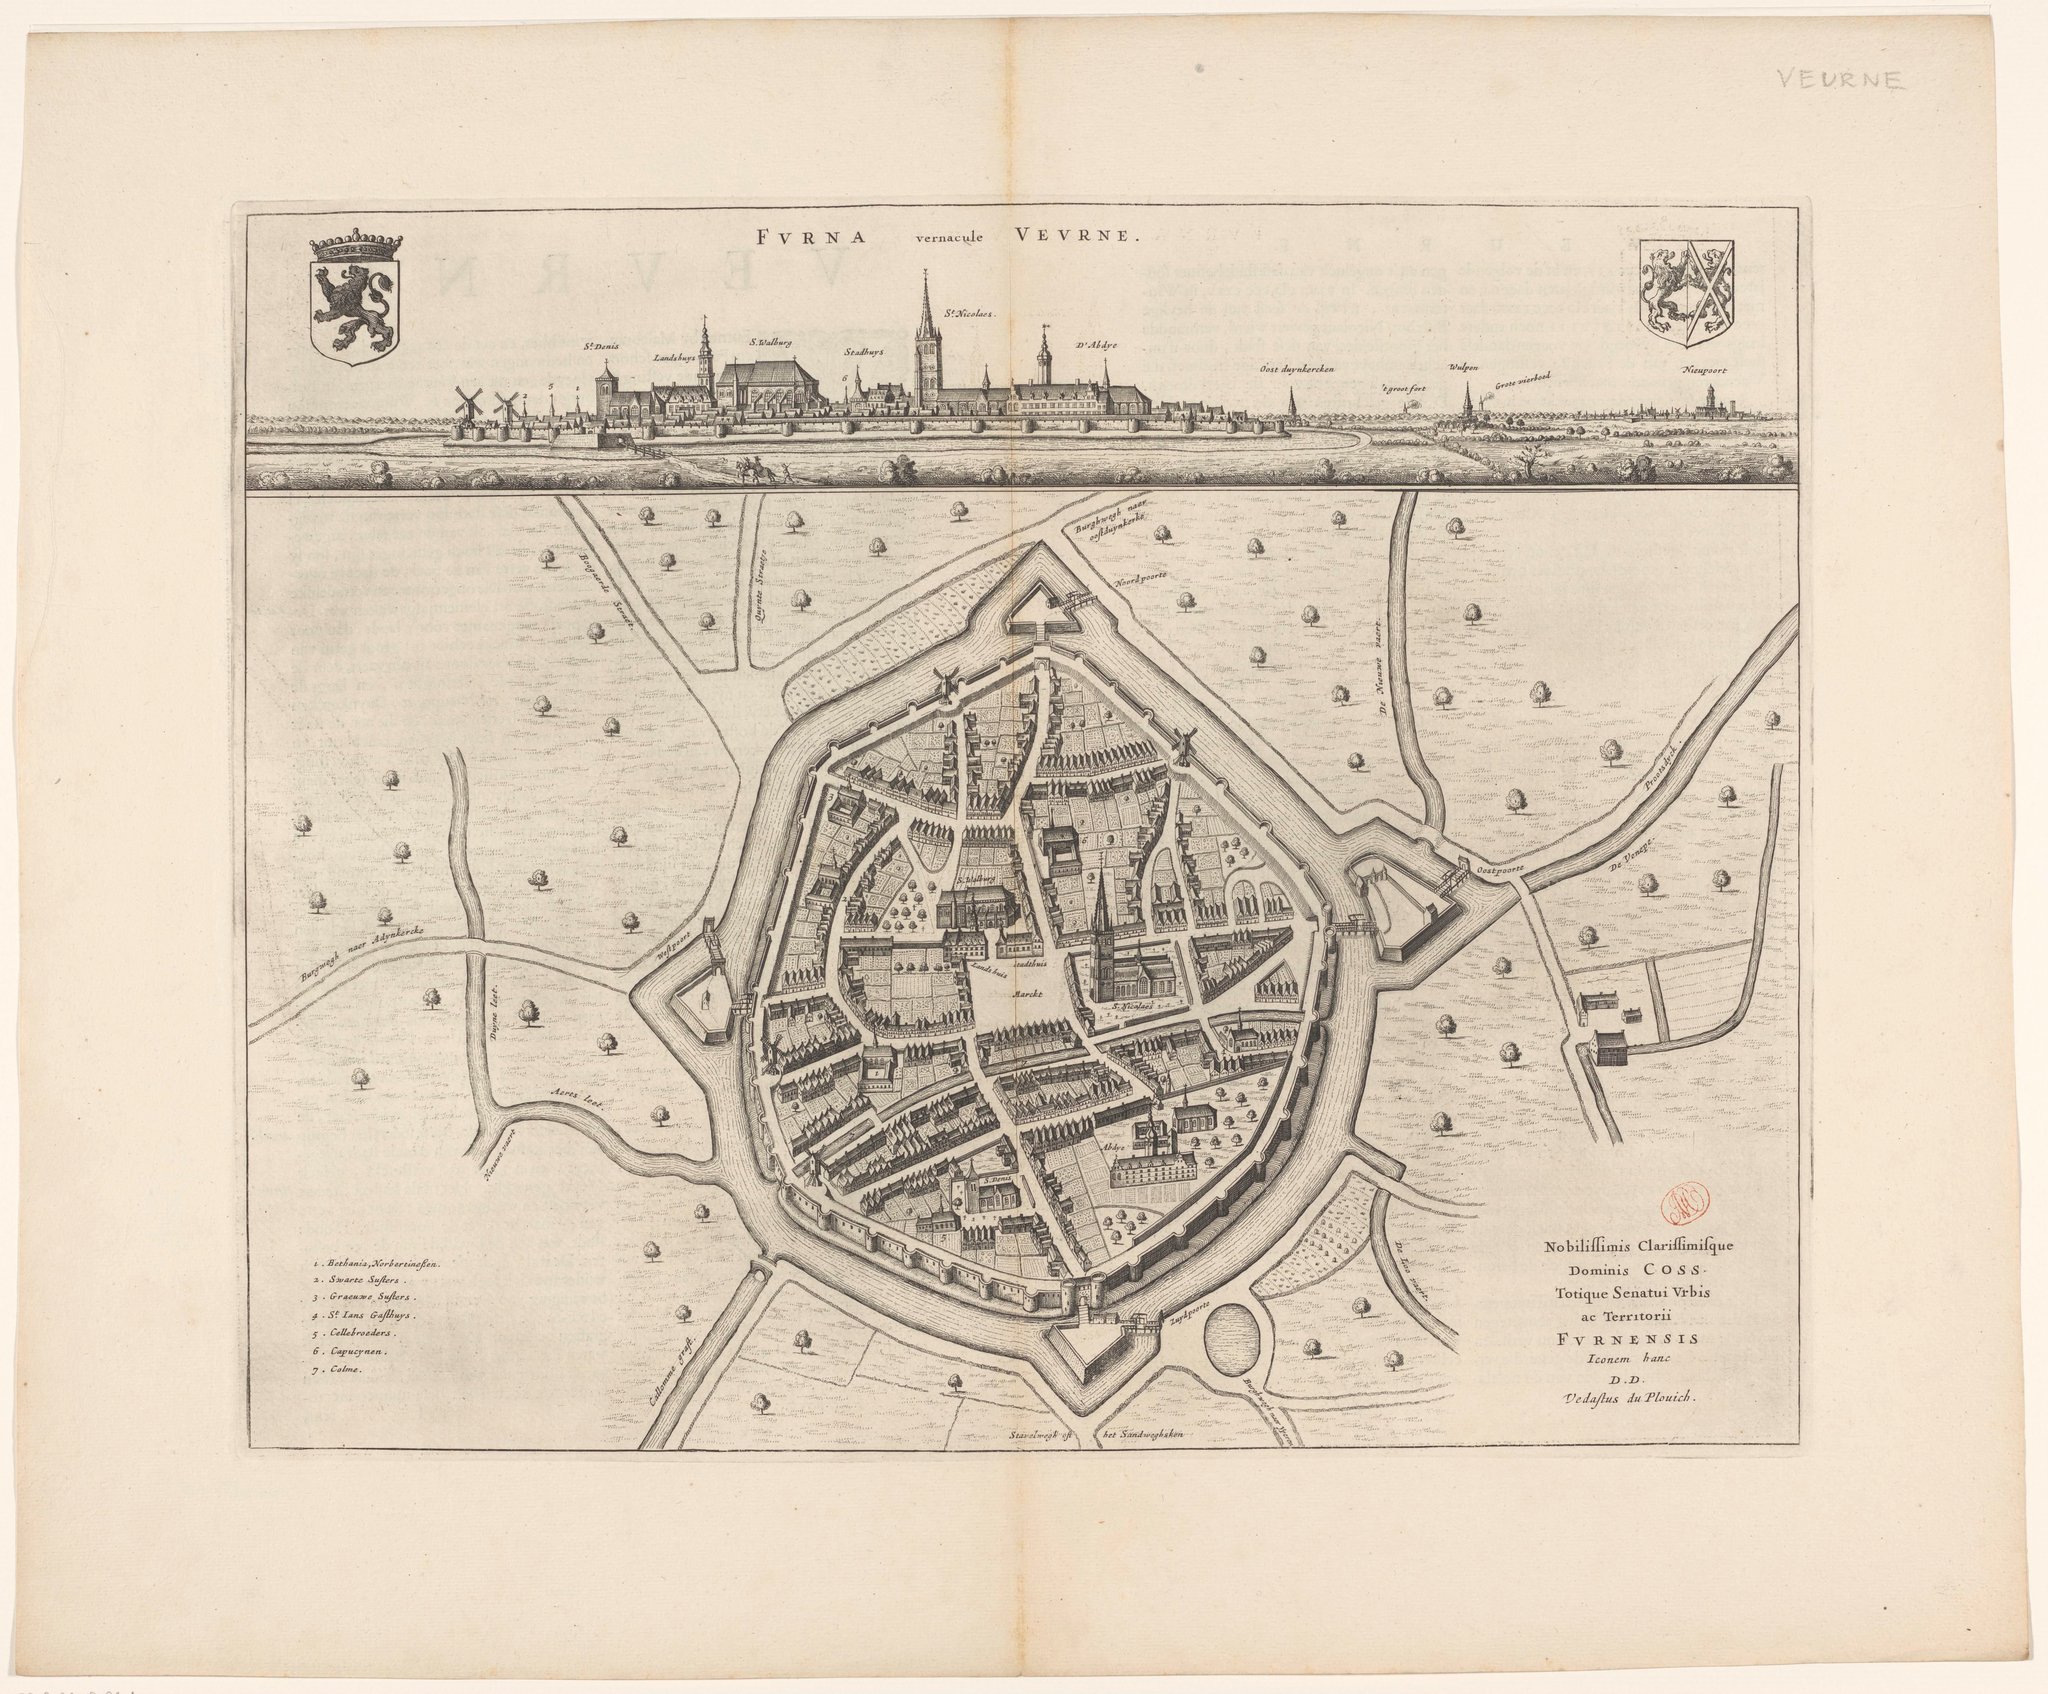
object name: area plan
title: Furna vernacule Veurne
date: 1652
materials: paper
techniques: engraving, etching, letterpress printing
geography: amsterdam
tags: coat of arms (as symbol of the state, etc.) (+ city; municipal), maps of cities, coat of arms (as symbol of the state, etc.) (+ province; provincial), prospect of city, town panorama, silhouette of city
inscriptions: collector's mark: Lugt 195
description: Boven een gezicht op Veurne, met links het wapen van Vlaanderen en rechts een wapen dat verwijst naar Veurne en de kasselrij Veurne. Hieronder een plattegrond van Veurne met gebouwen in vogelvluchtperspectief. Linksonder een legenda 1-7. Met Nederlandse tekst op verso.